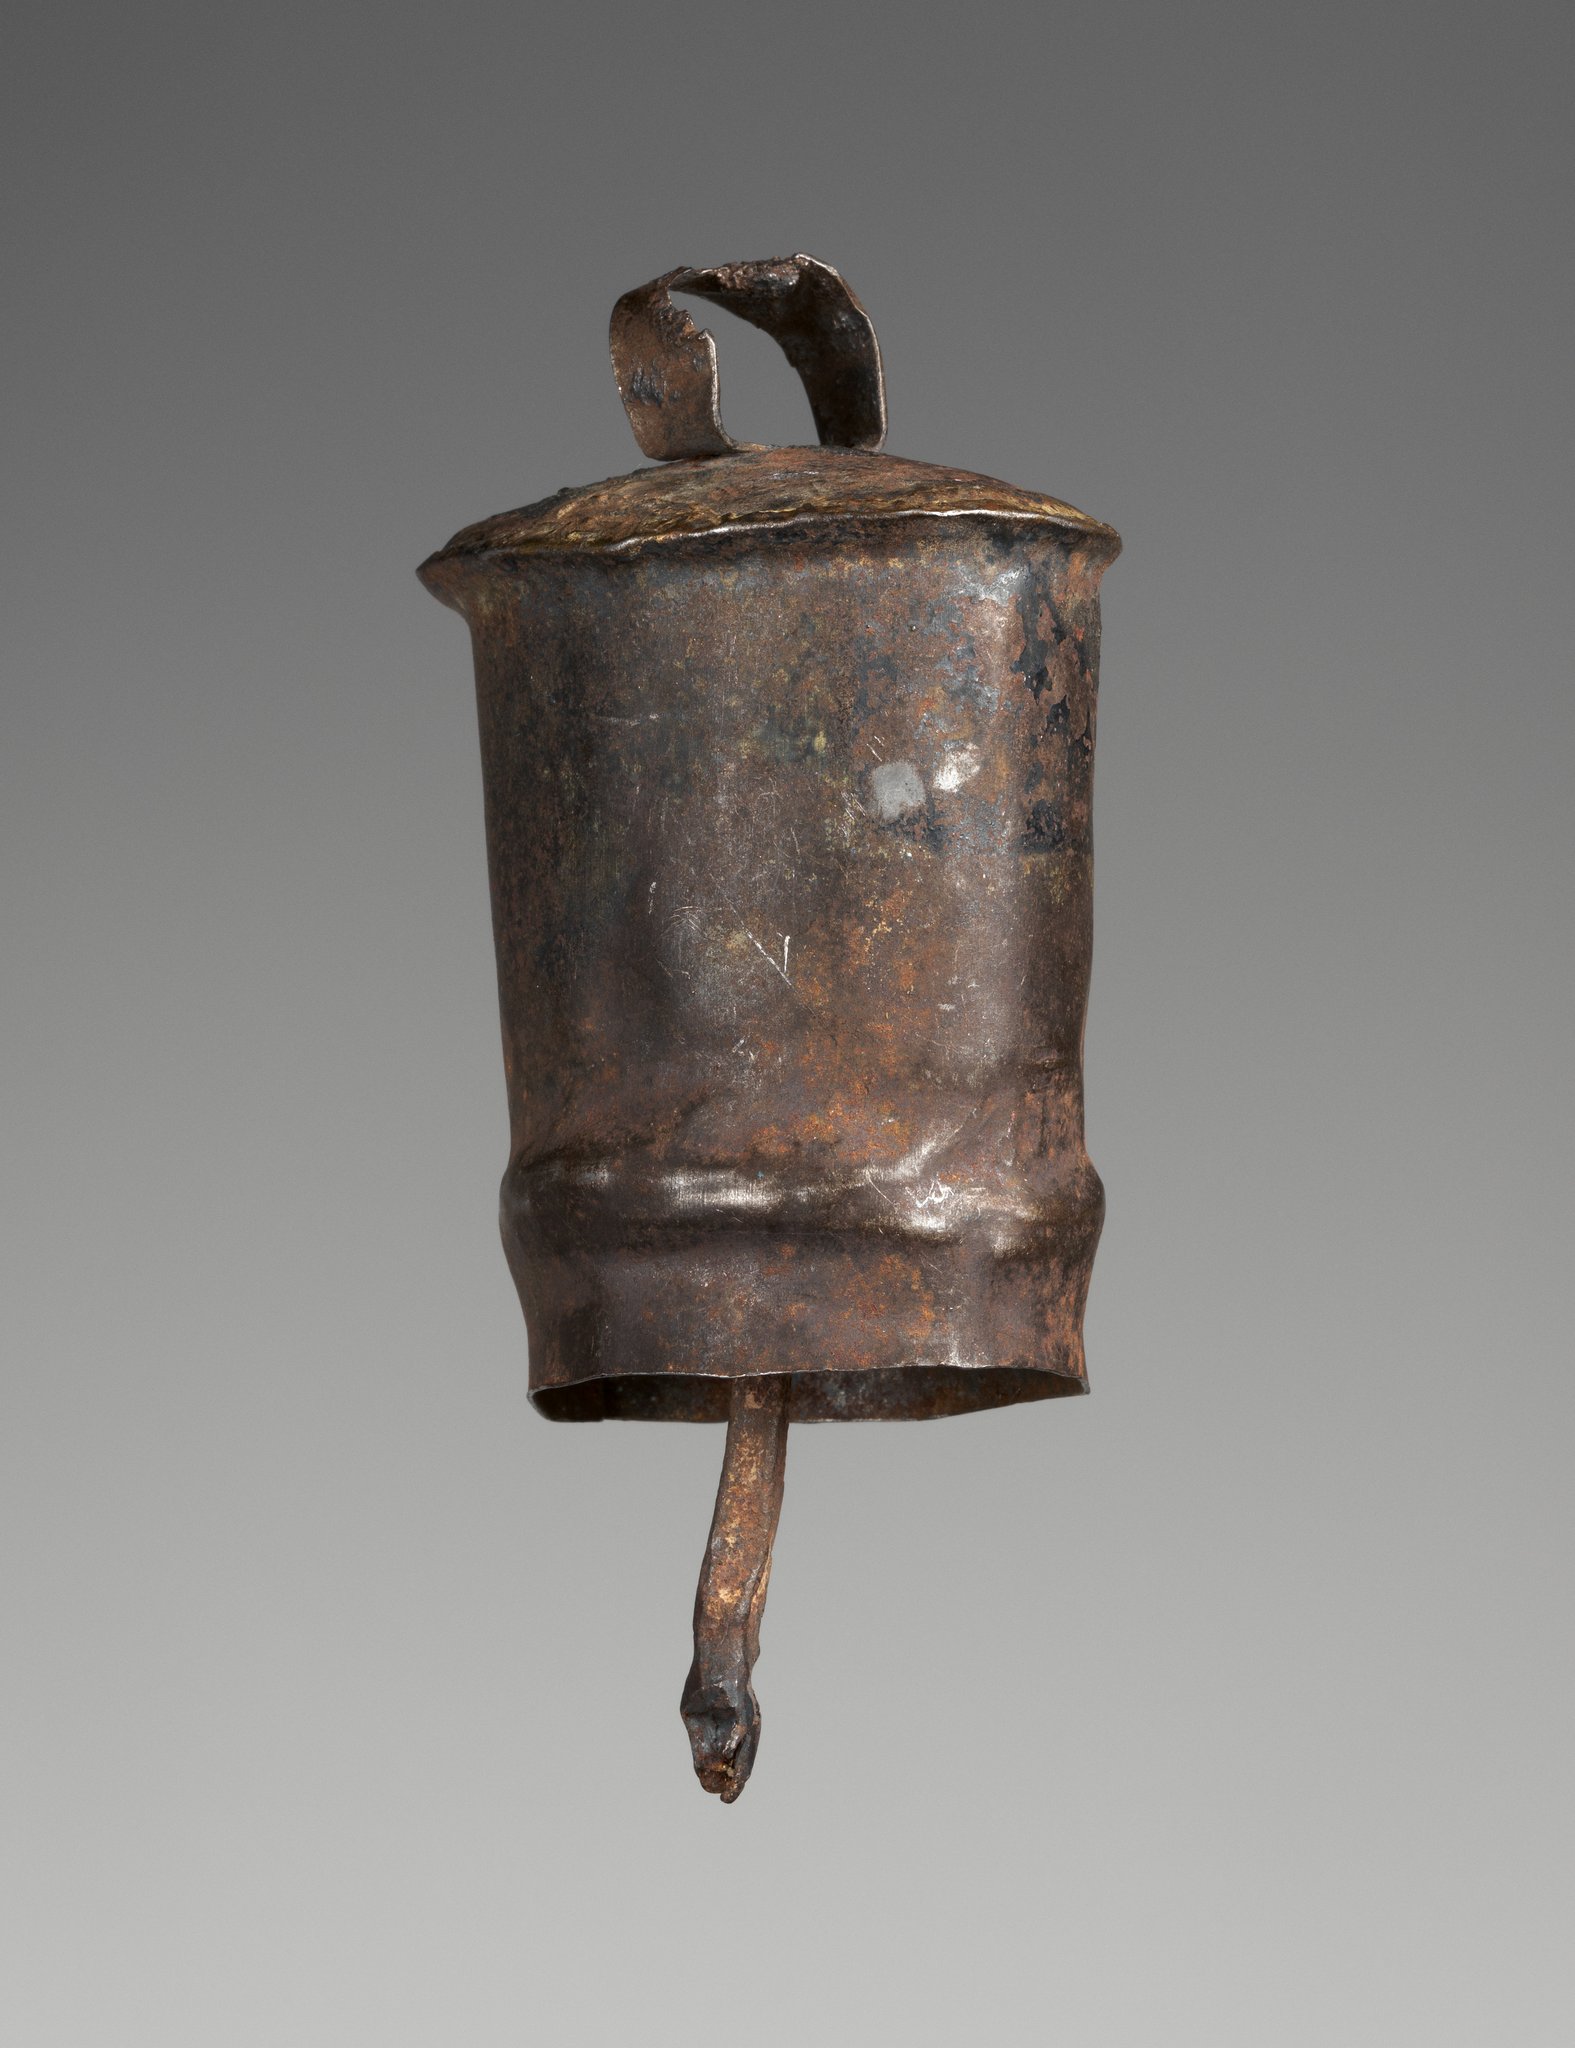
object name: sheep bell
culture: afghan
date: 1934-1966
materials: iron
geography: afghanistan